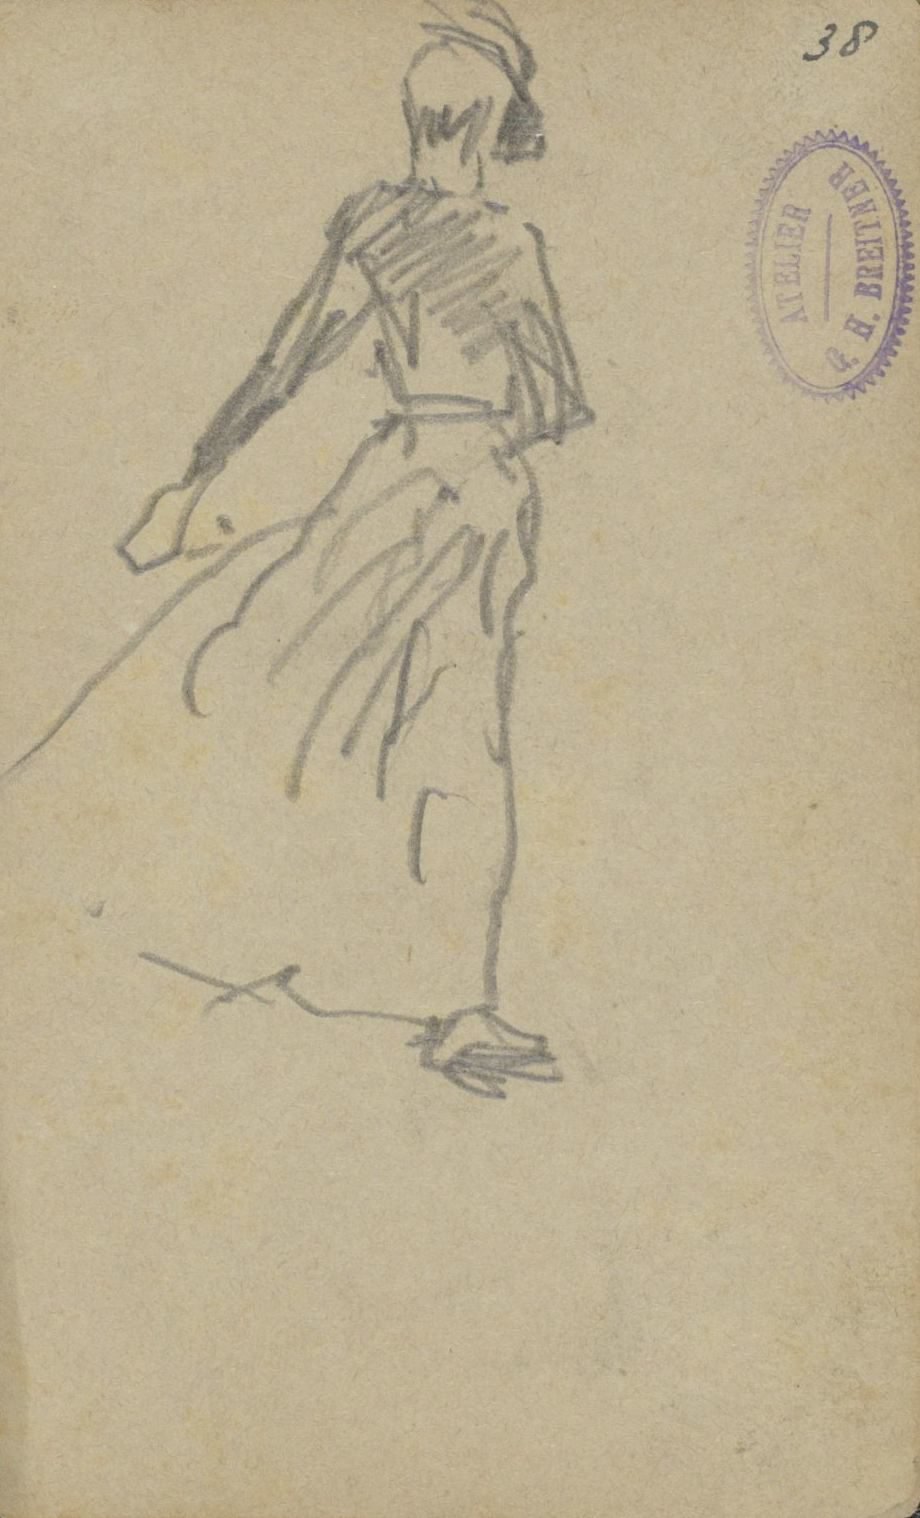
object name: drawing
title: Staande vrouw met wapperende rok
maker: george hendrik breitner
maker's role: draughtsman, painter, print maker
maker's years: 1857-1923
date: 1887-1891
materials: paper, pencil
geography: gelderland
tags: standing figure - aa - female human figure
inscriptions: workshop stamp: Lugt 291d